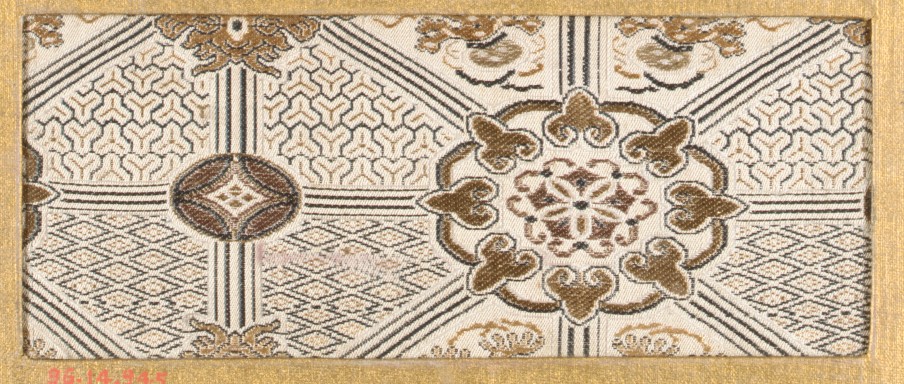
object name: piece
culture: japanese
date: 1701-1900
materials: silk